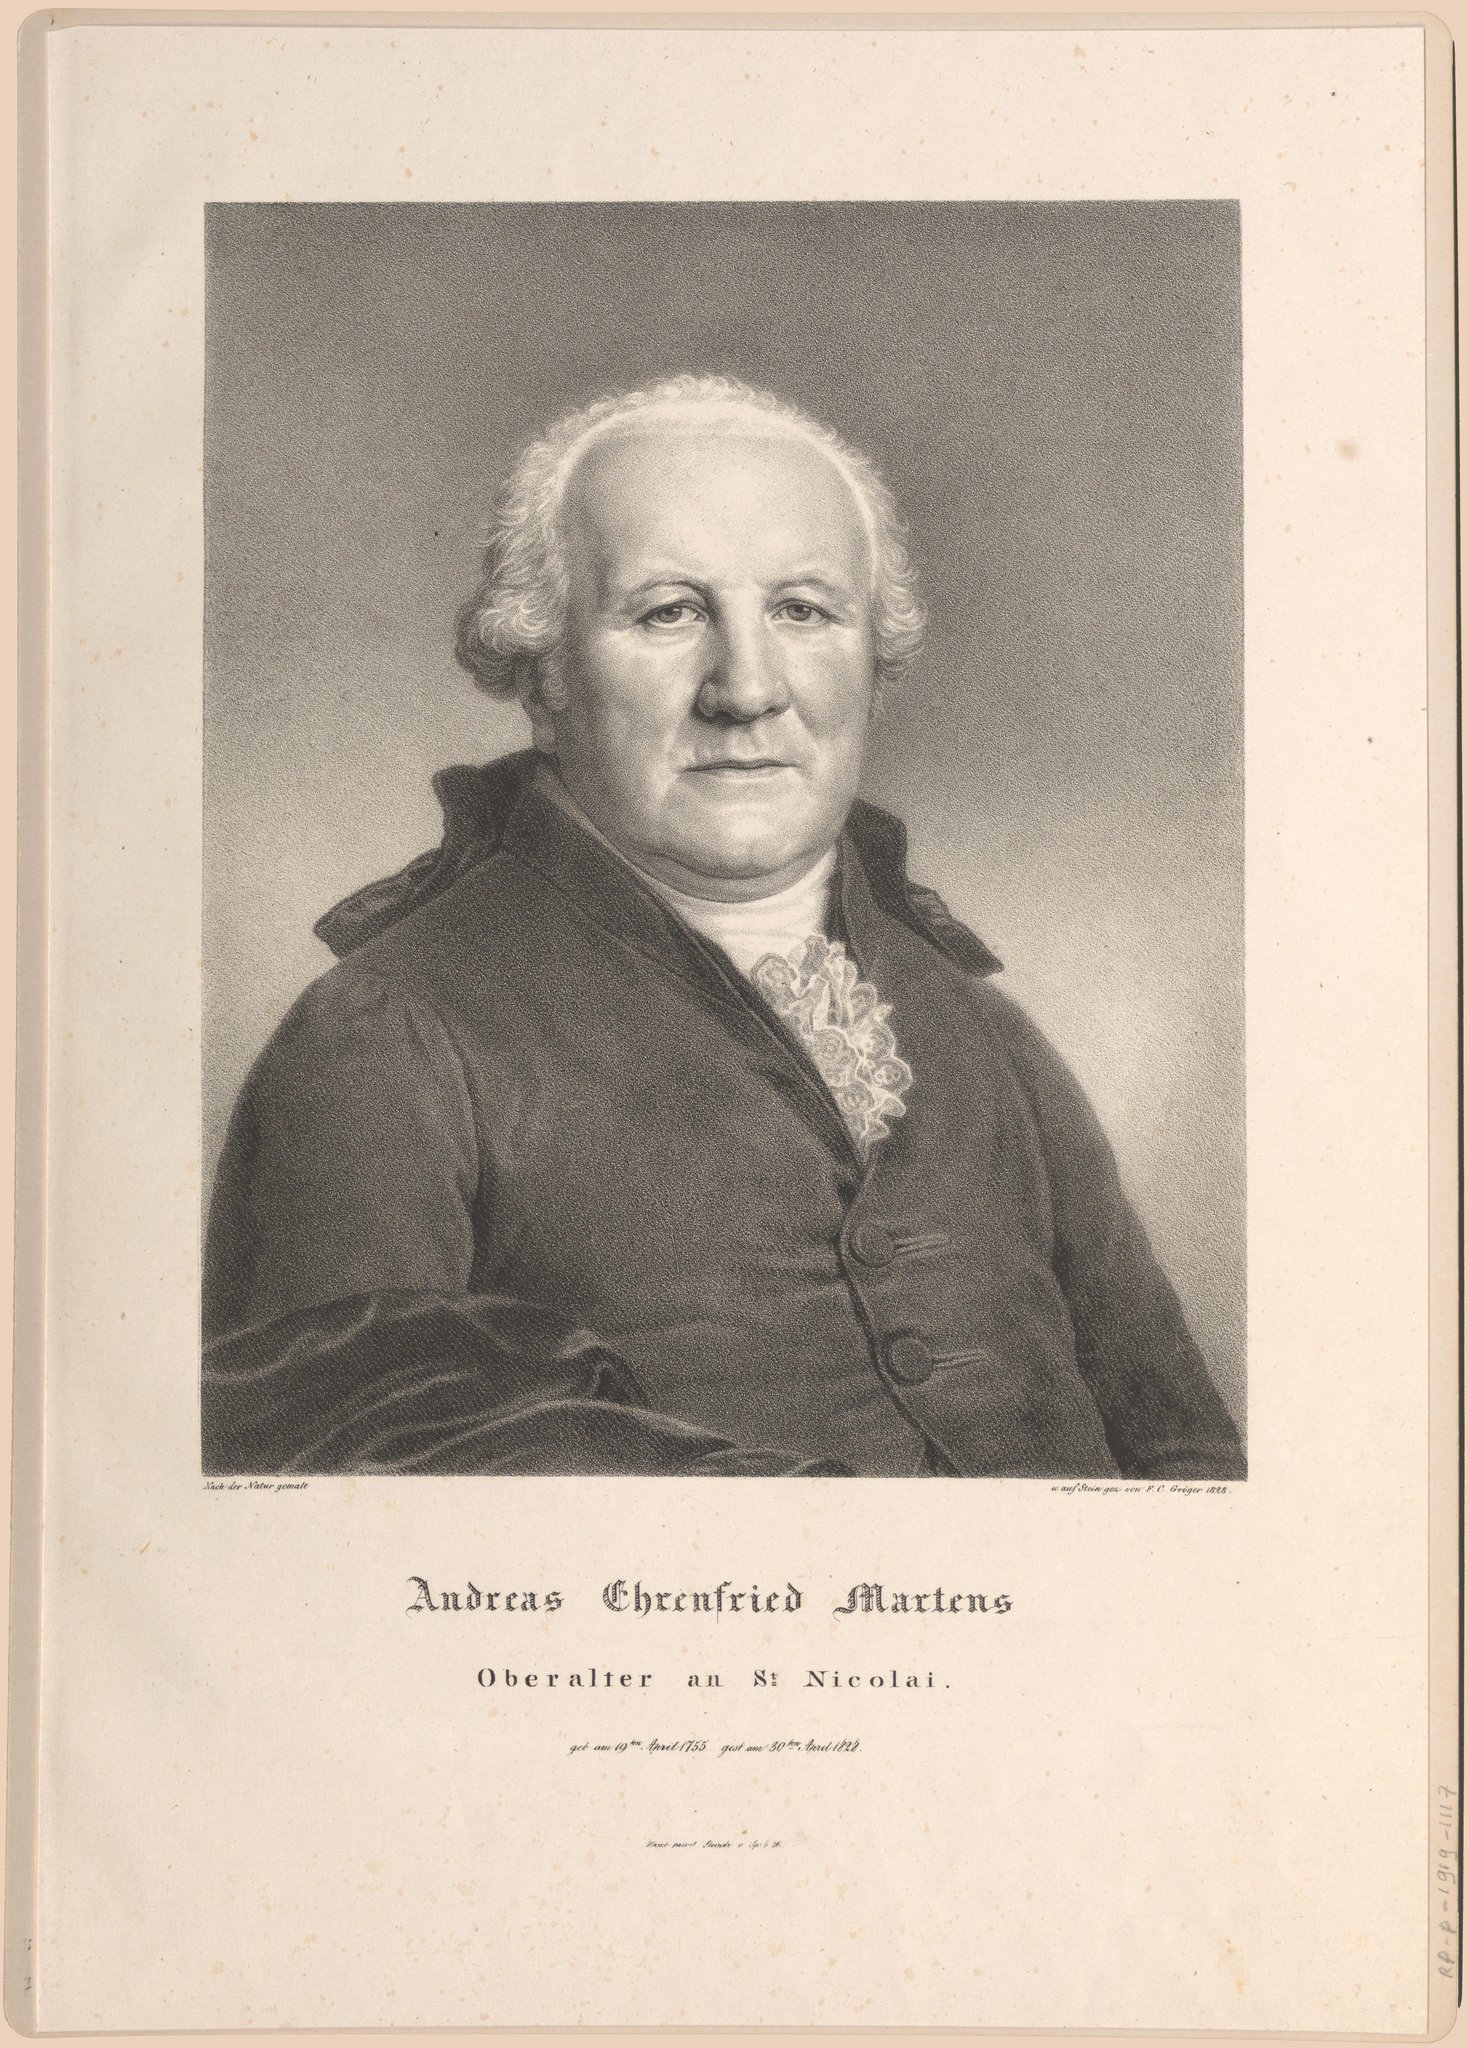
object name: print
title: Portret van Andreas Ehrenfried Martens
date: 1828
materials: paper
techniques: lithograph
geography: hamburg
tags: historical persons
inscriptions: collector's mark: Lugt 2228